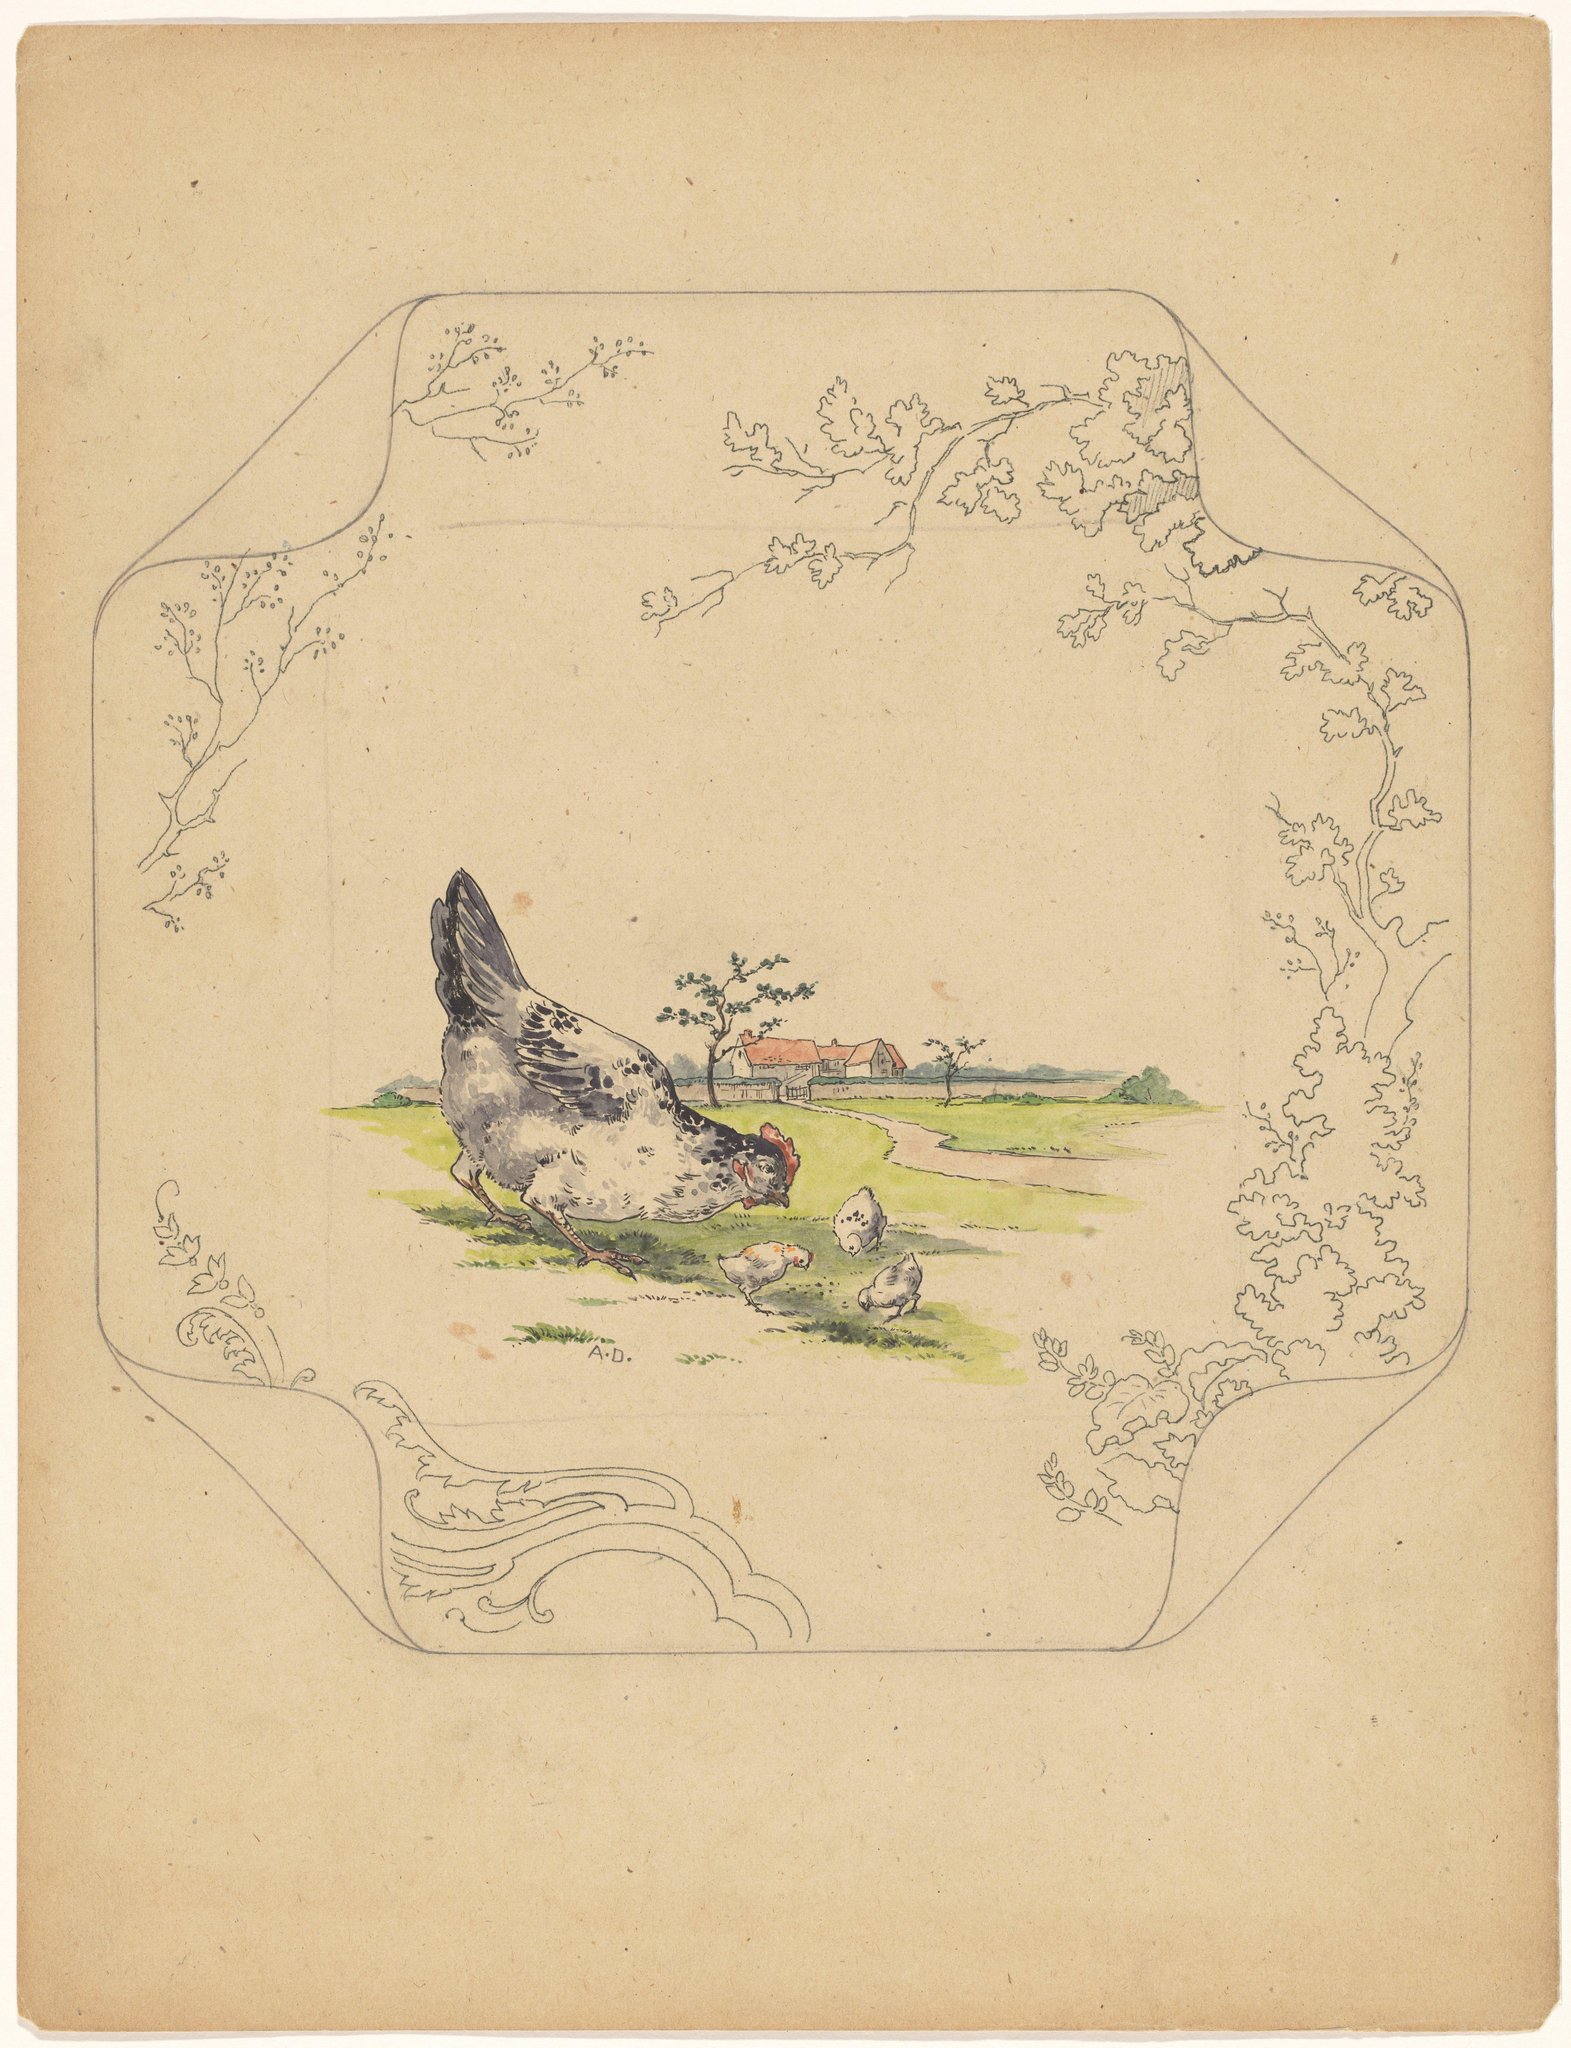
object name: drawing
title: Ontwerp voor bord van het model ‘Square’ met een hen en drie kuikens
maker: albert louis dammouse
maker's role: ceramicist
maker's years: 1848-1926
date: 1875-1880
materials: graphite, ink, paper, watercolor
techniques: brush, pen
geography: sèvres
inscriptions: monogram: ‘A.D.’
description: Het plat gedecoreerd met een hen met drie kuikens, enkele huizen op de achtergrond.